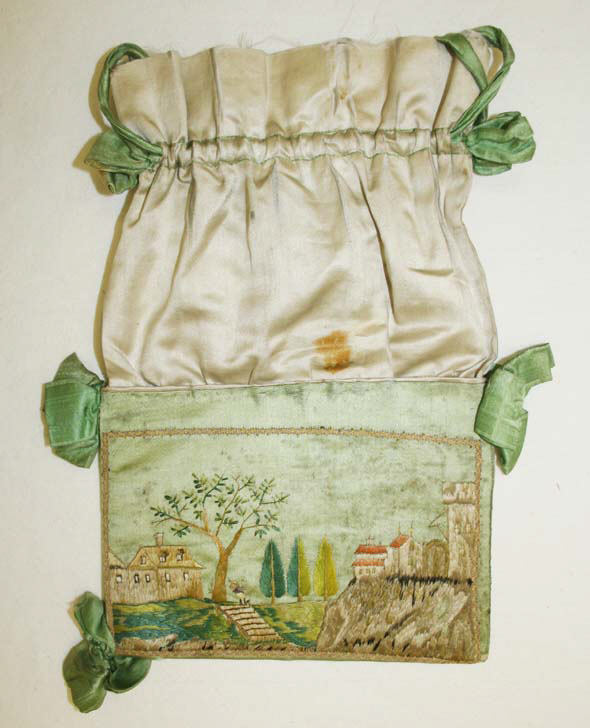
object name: reticule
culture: french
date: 1795-1800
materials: silk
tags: buildings